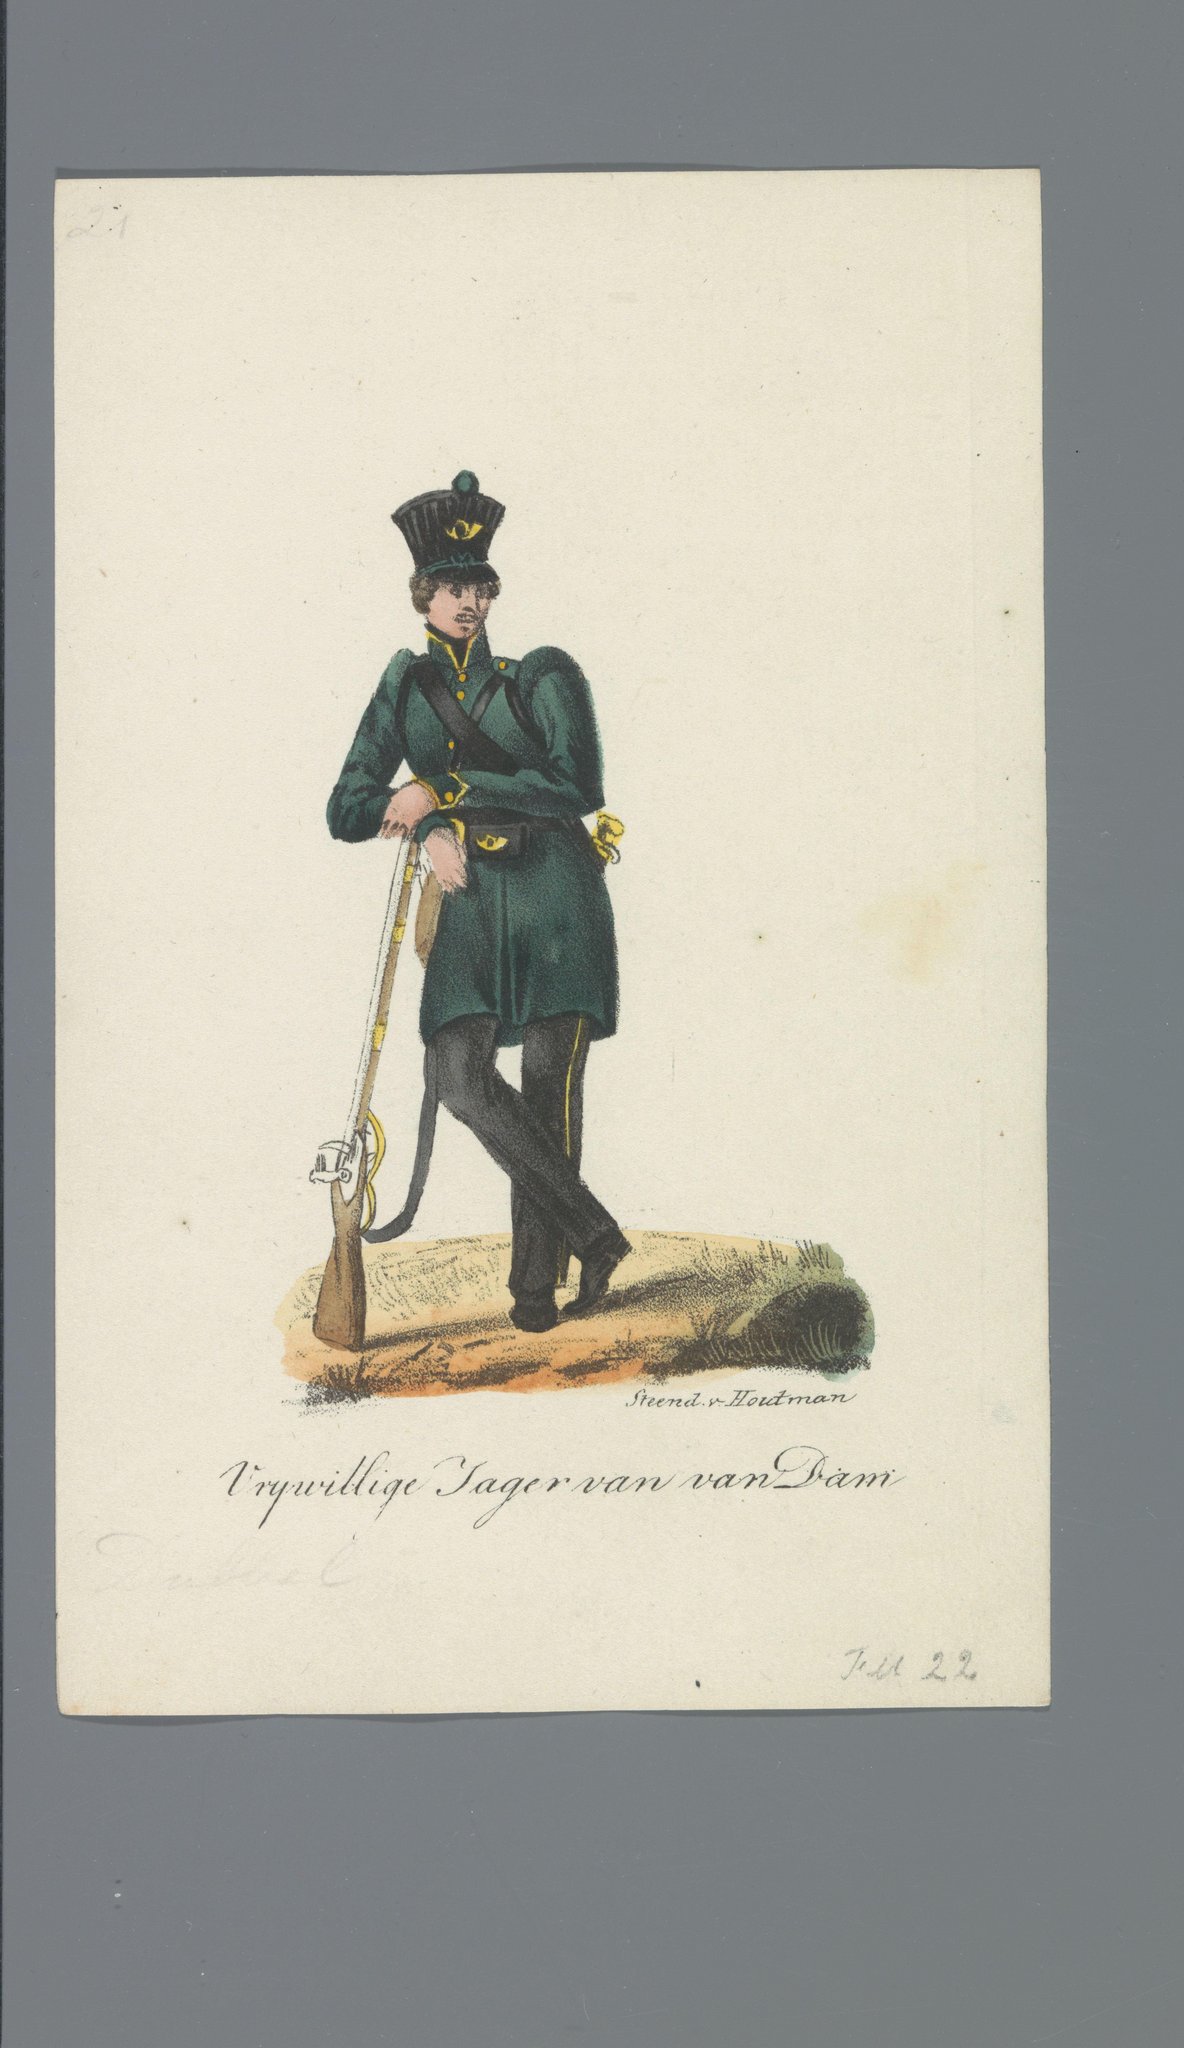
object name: print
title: Nederlandse militaire uniformen in de jaren 1830-1832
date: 1835-1850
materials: paper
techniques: hand coloring, lithograph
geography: utrecht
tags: (military) uniforms, clothes, costume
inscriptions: collector's mark: Lugt 2228, collector's mark: Lugt 2227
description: Staande jager van de Compagnie Vrijwillige Jagers van Van Dam. Onderdeel van een serie van 157 losse bladen met Nederlandse militaire uniformen in de jaren 1830-1832.